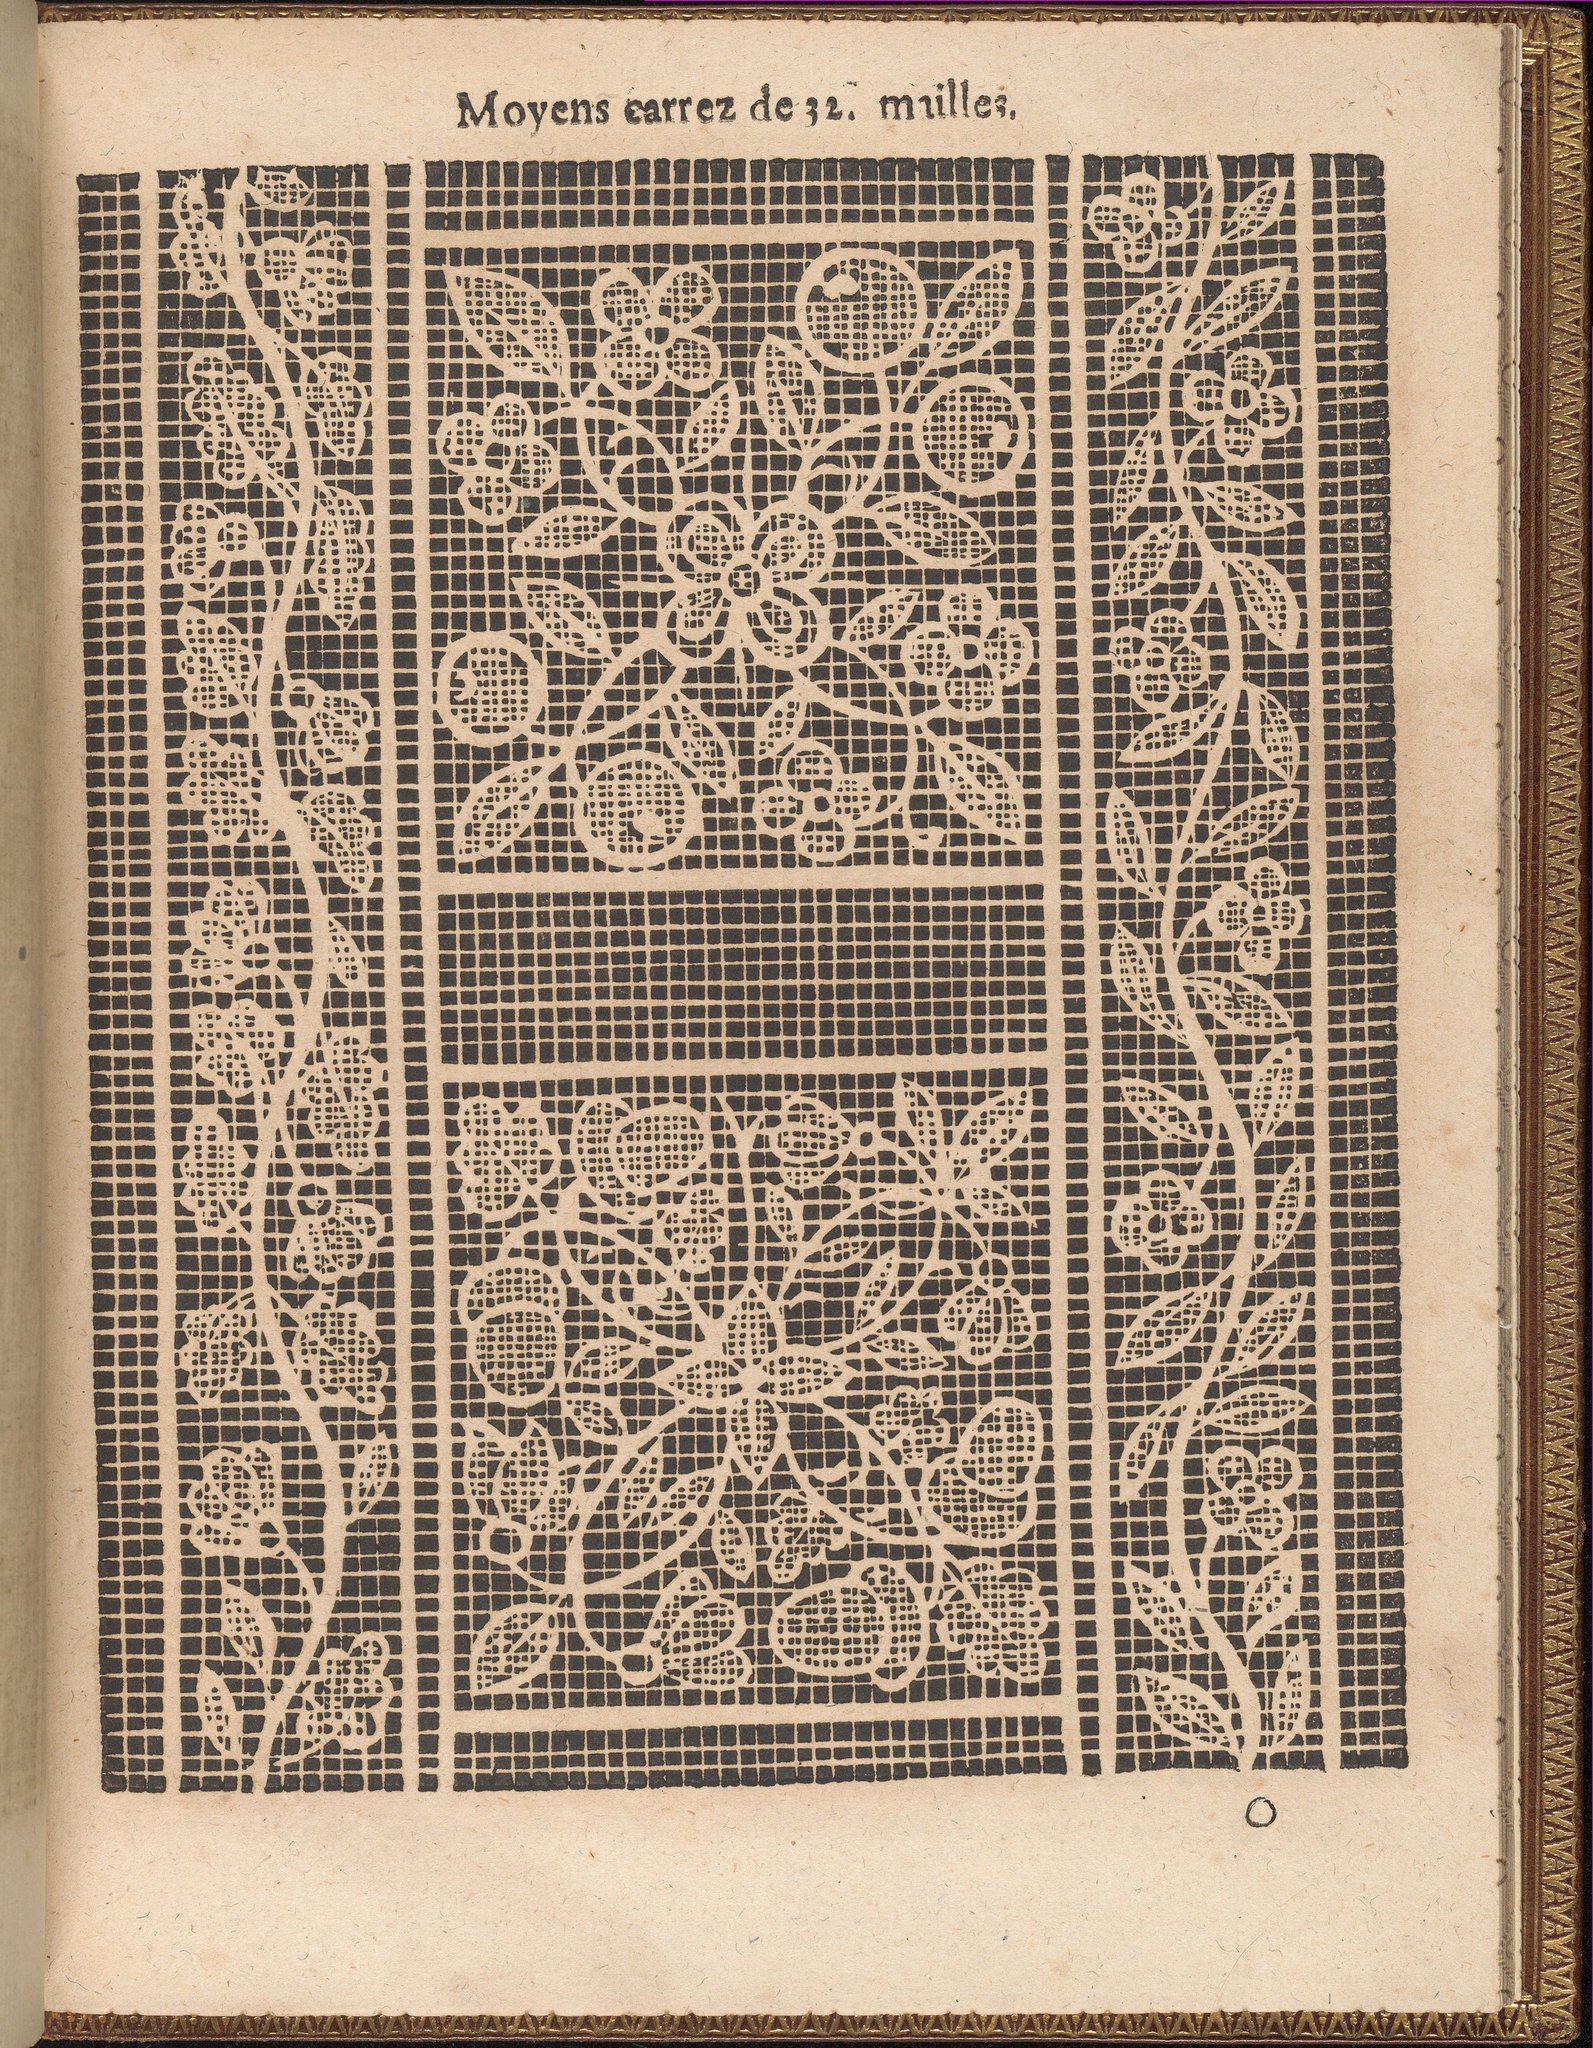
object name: book print ornament architecture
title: La Pratique de l'Aiguille, page 52 (recto)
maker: matthias mignerak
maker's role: author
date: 1605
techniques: woodcut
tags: flowers